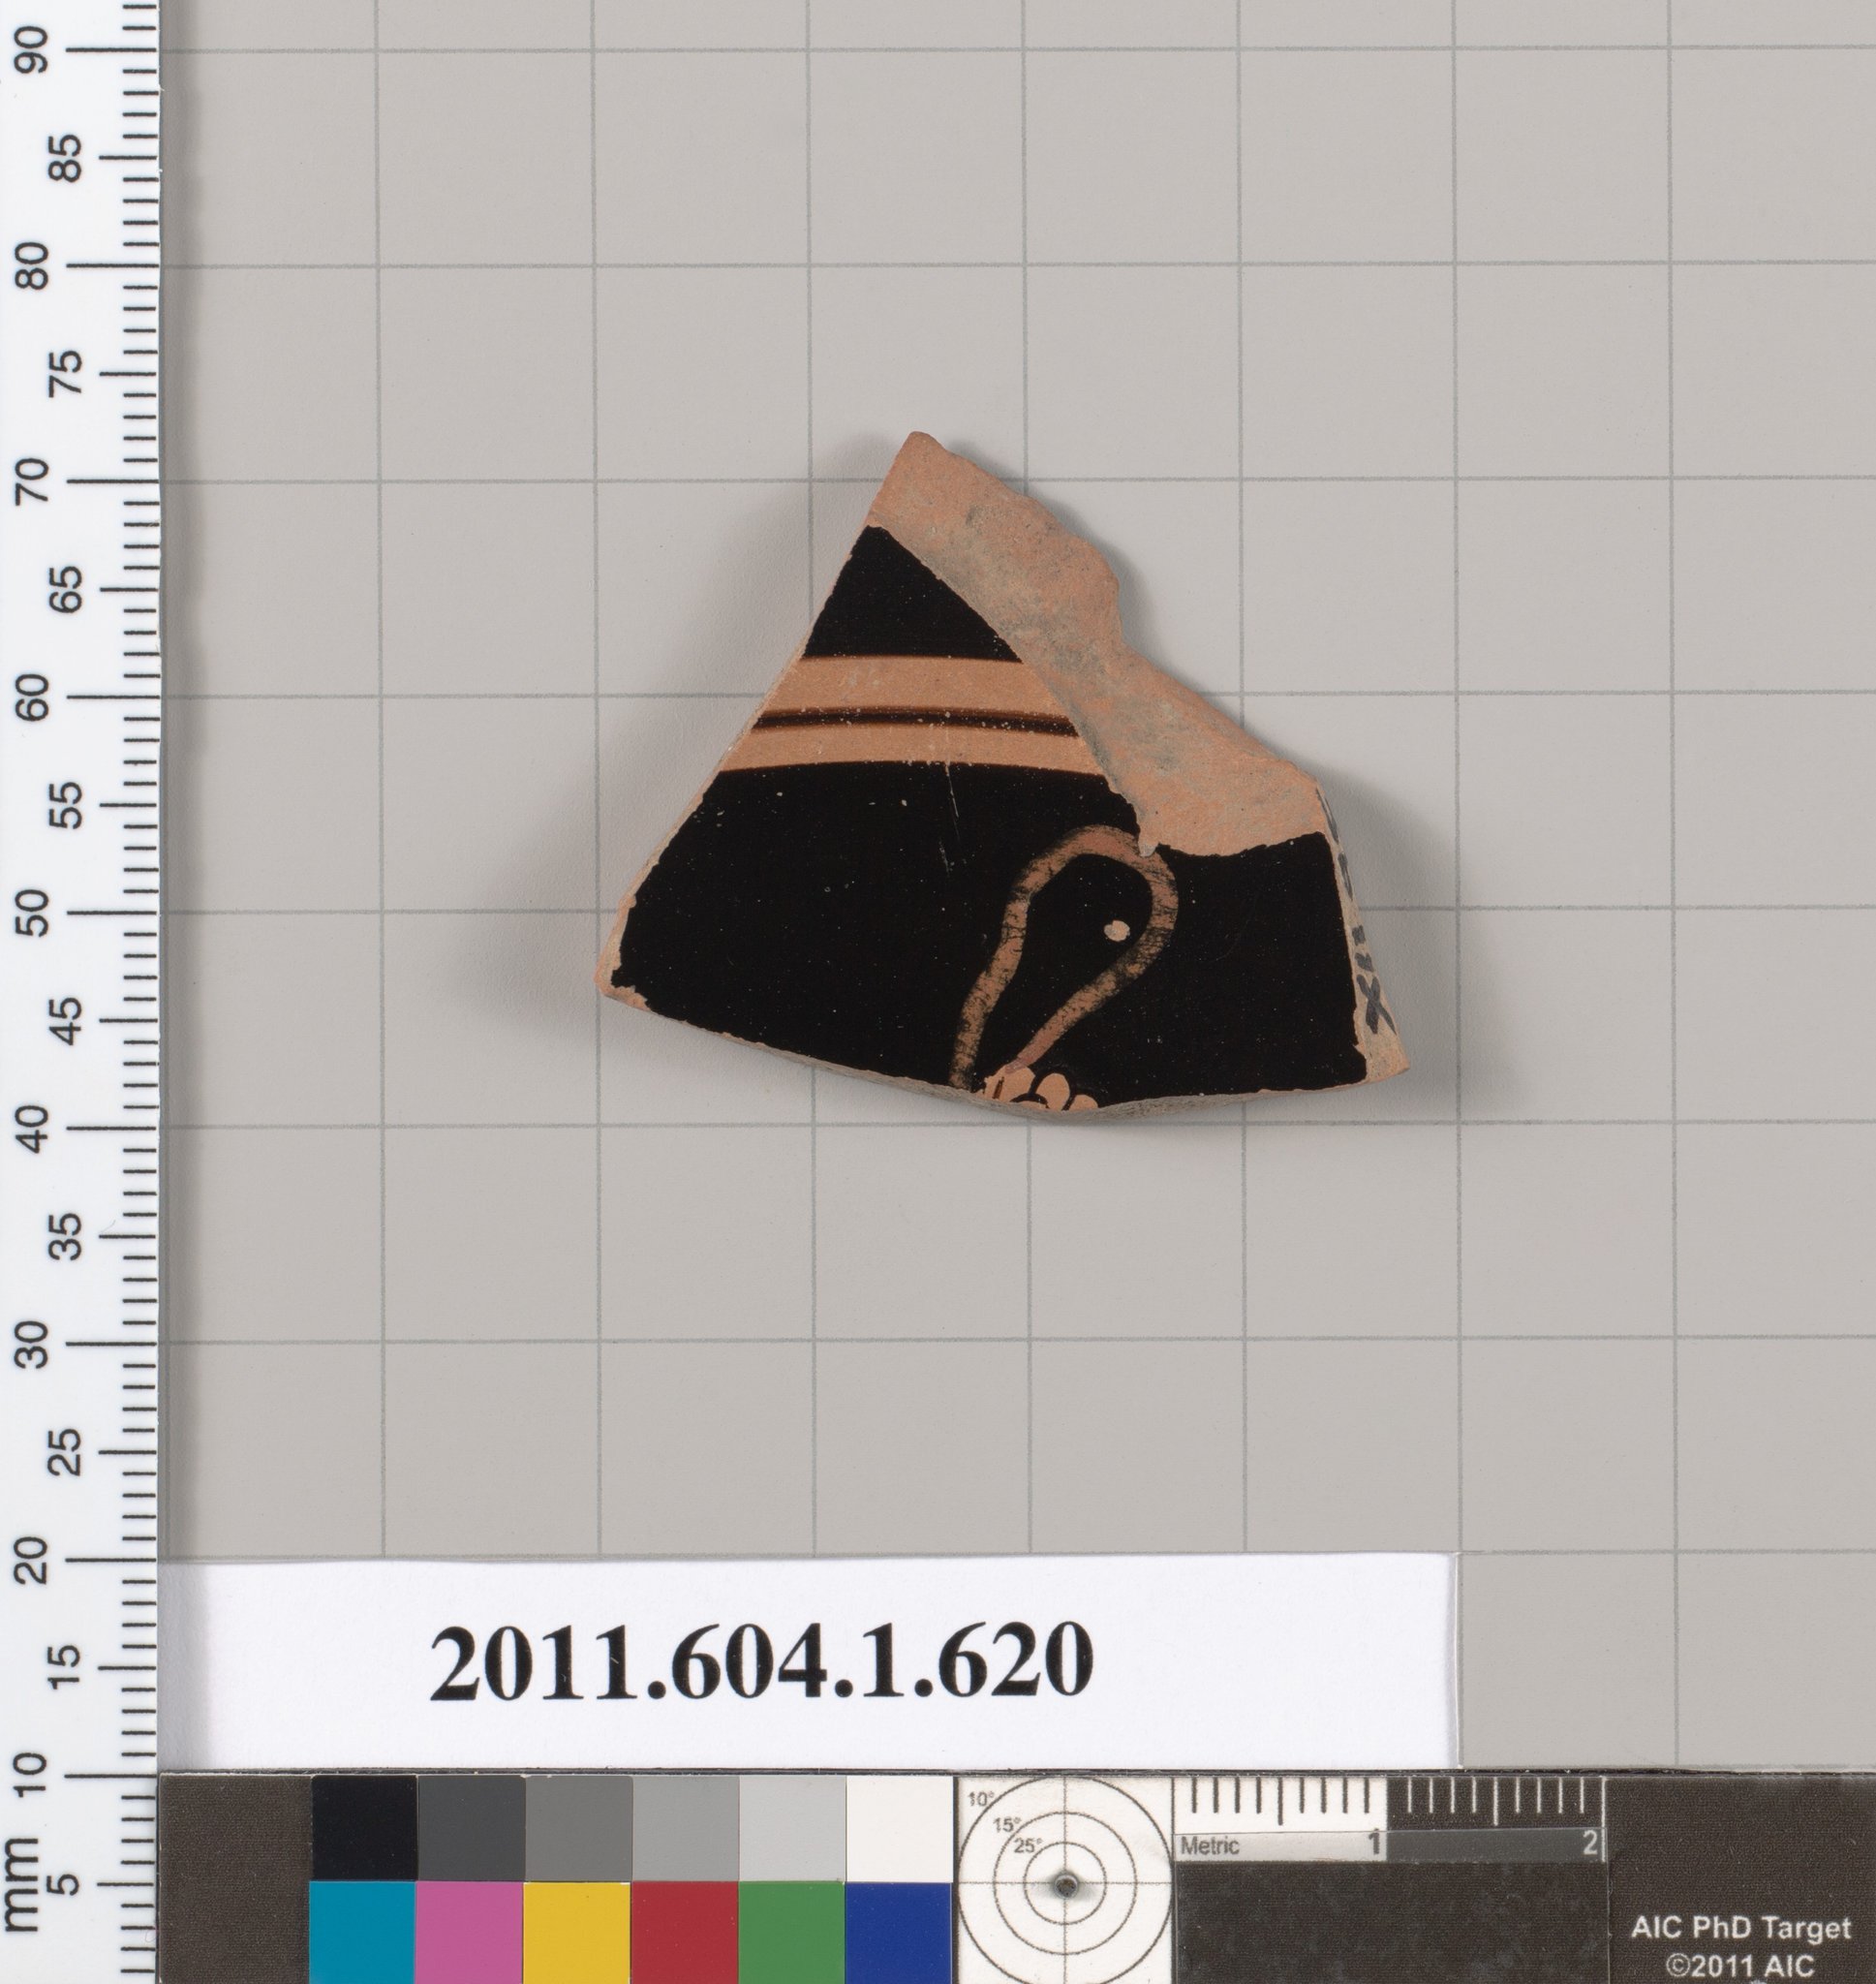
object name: kylix fragment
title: Terracotta fragment of a kylix (drinking cup)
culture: greek, attic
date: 475-451 BCE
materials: terracotta